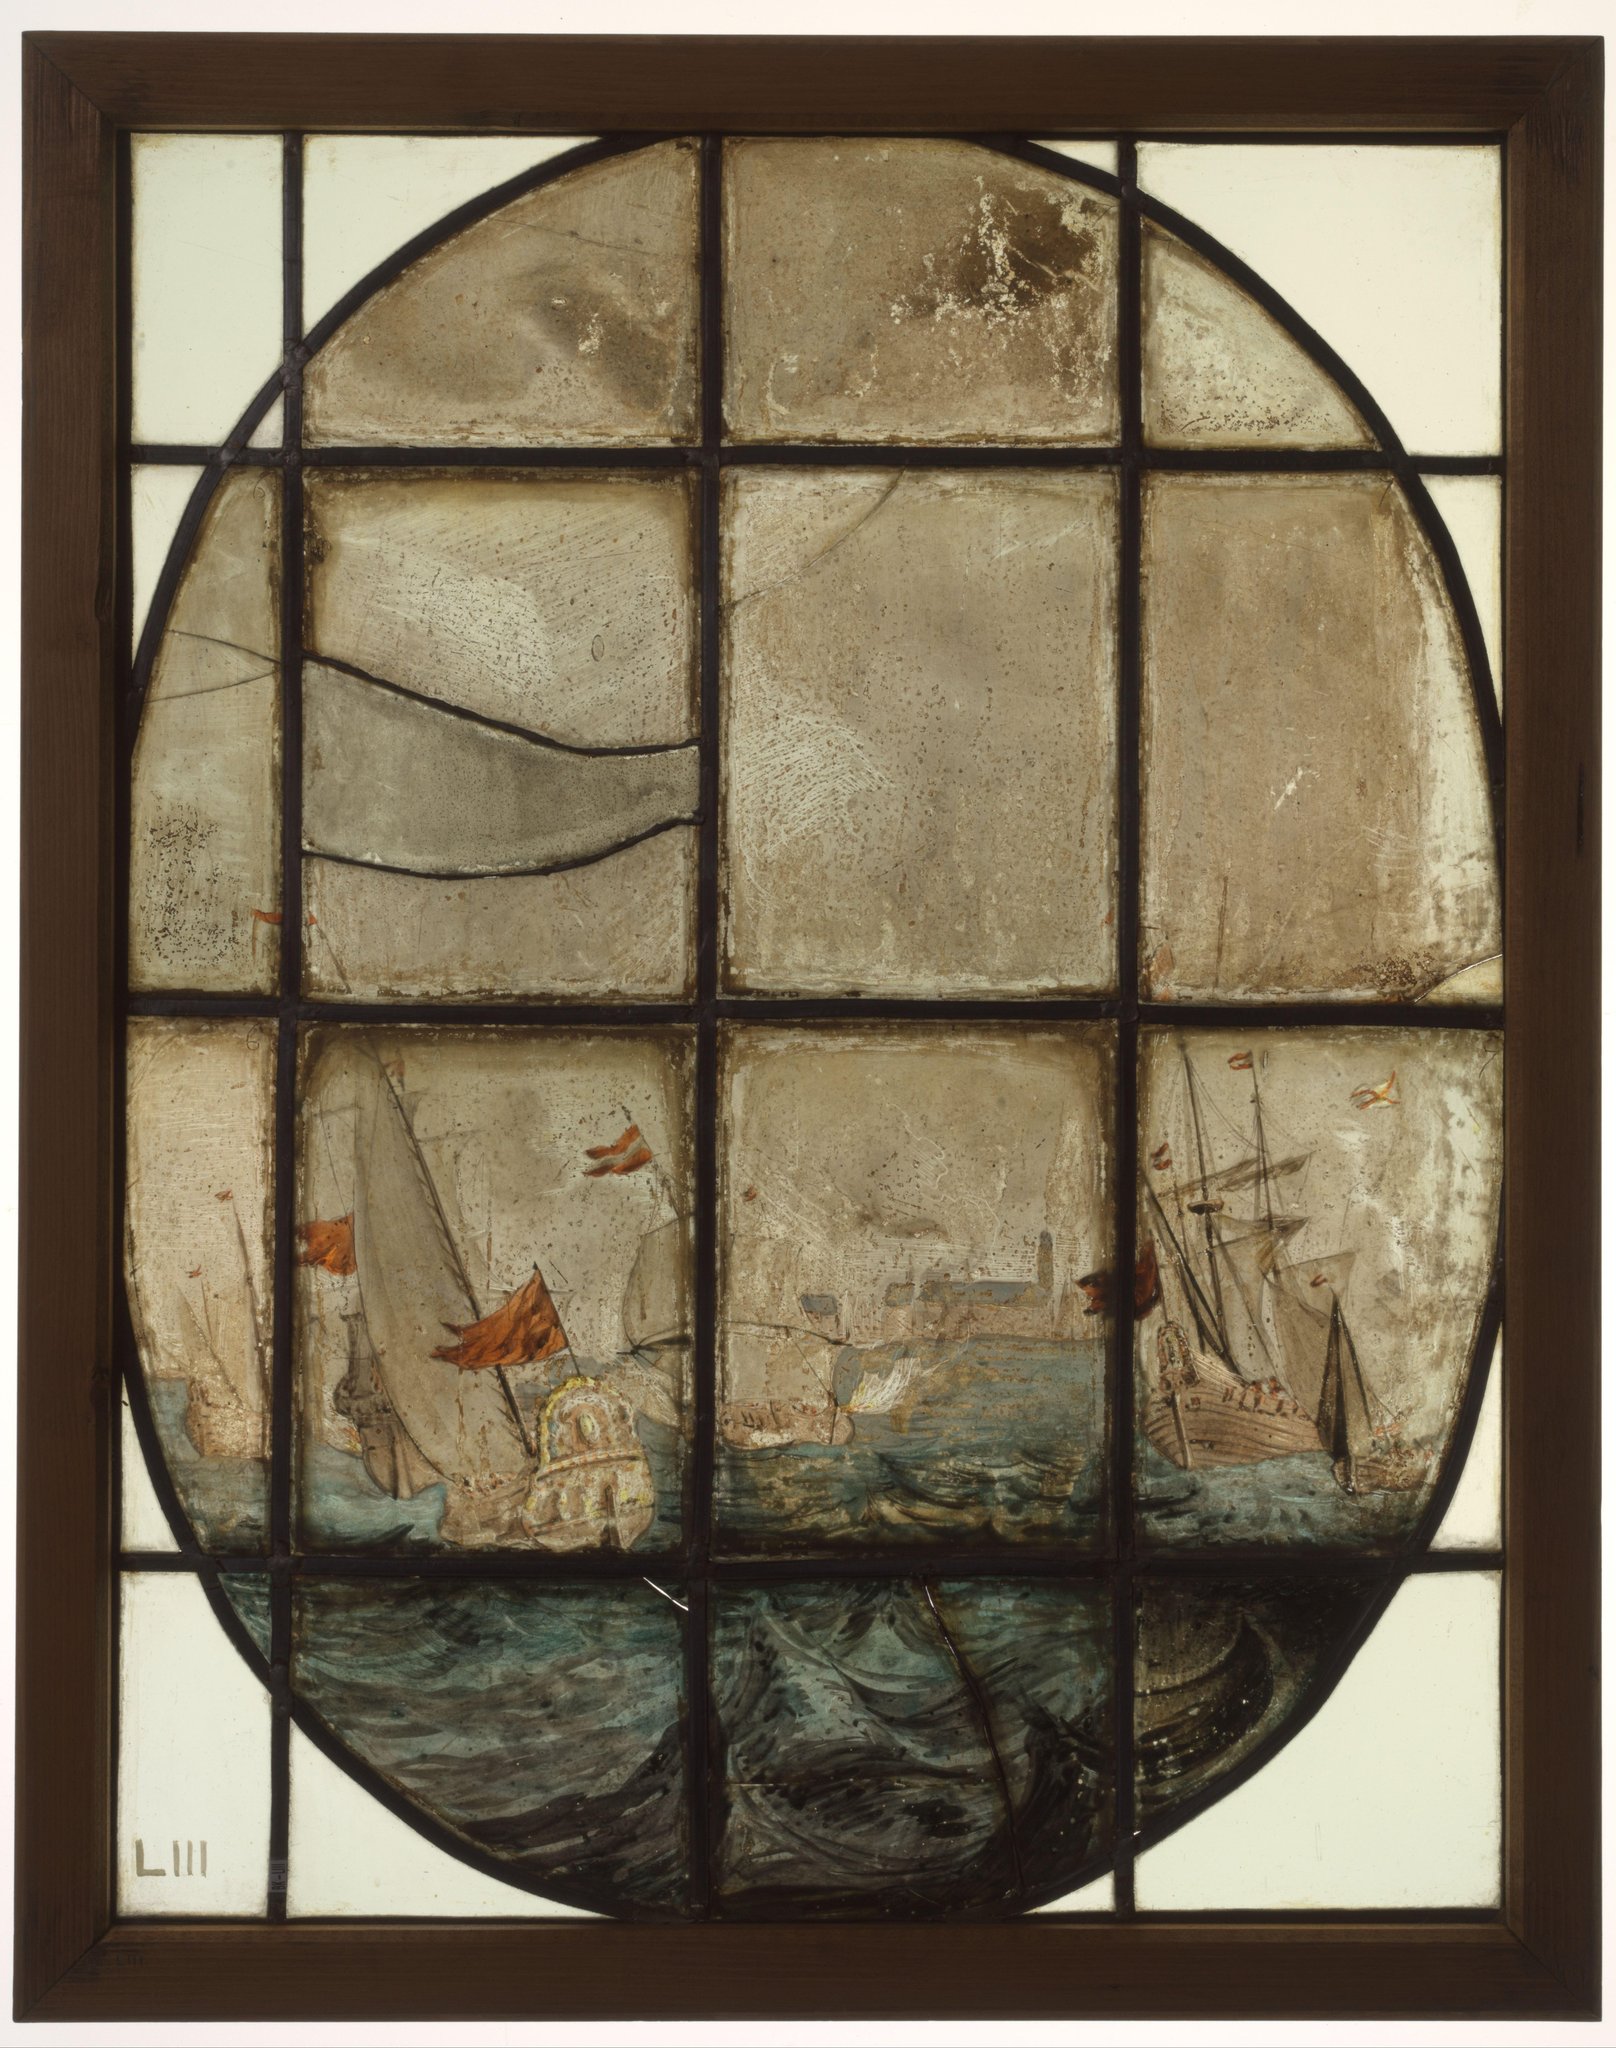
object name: light window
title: Ruit met zeeschepen nabij een haven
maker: Anonymous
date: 1600-1699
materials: glass, lead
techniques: leading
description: Ruit waarop afgebeeld zeeschepen een zeehaven binnenzeilende, in een ovaal.